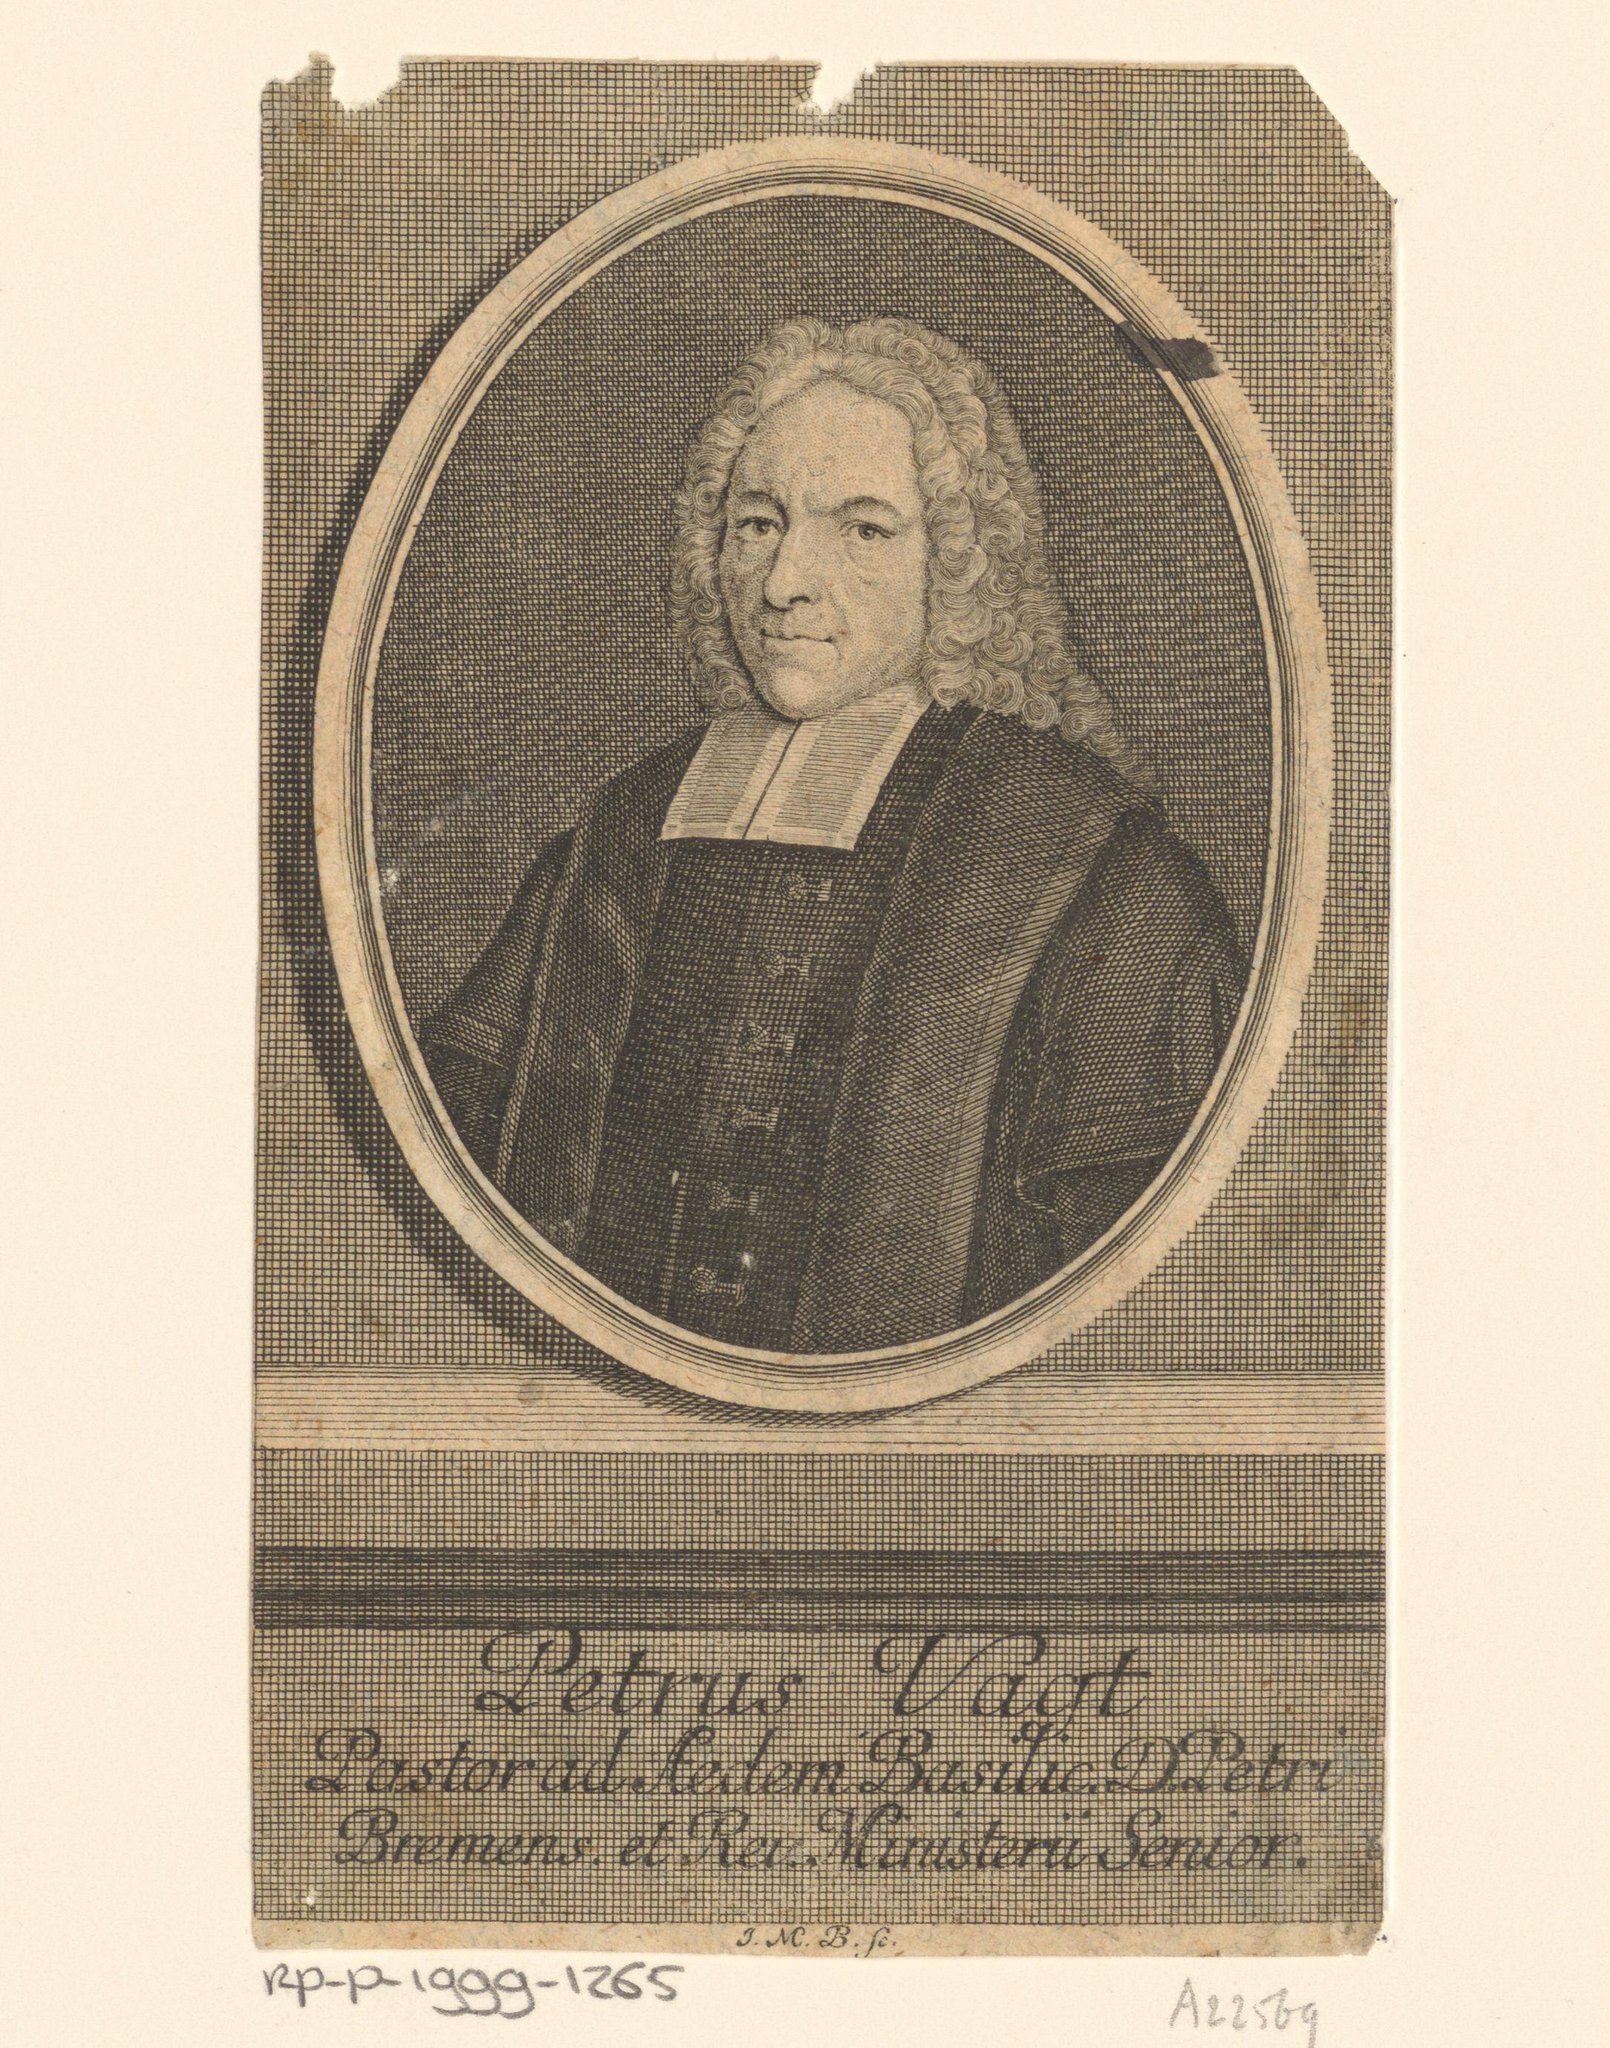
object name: print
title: Portret van Petrus Vagt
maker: johann martin bernigeroth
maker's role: print maker, publisher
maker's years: 1713-1767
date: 1741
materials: paper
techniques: engraving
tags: theologian, historical persons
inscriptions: collector's mark: Lugt 2228, collector's mark: Lugt 2760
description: Prent waarschijnlijk uit: Zuverlagiße Nachrichten von gegenwärtigen Zustande, Veränderung und Wachstum der Wissenschaften. Leipzig: Johann Friedrich Gleditsch, 1741, dl. 18.